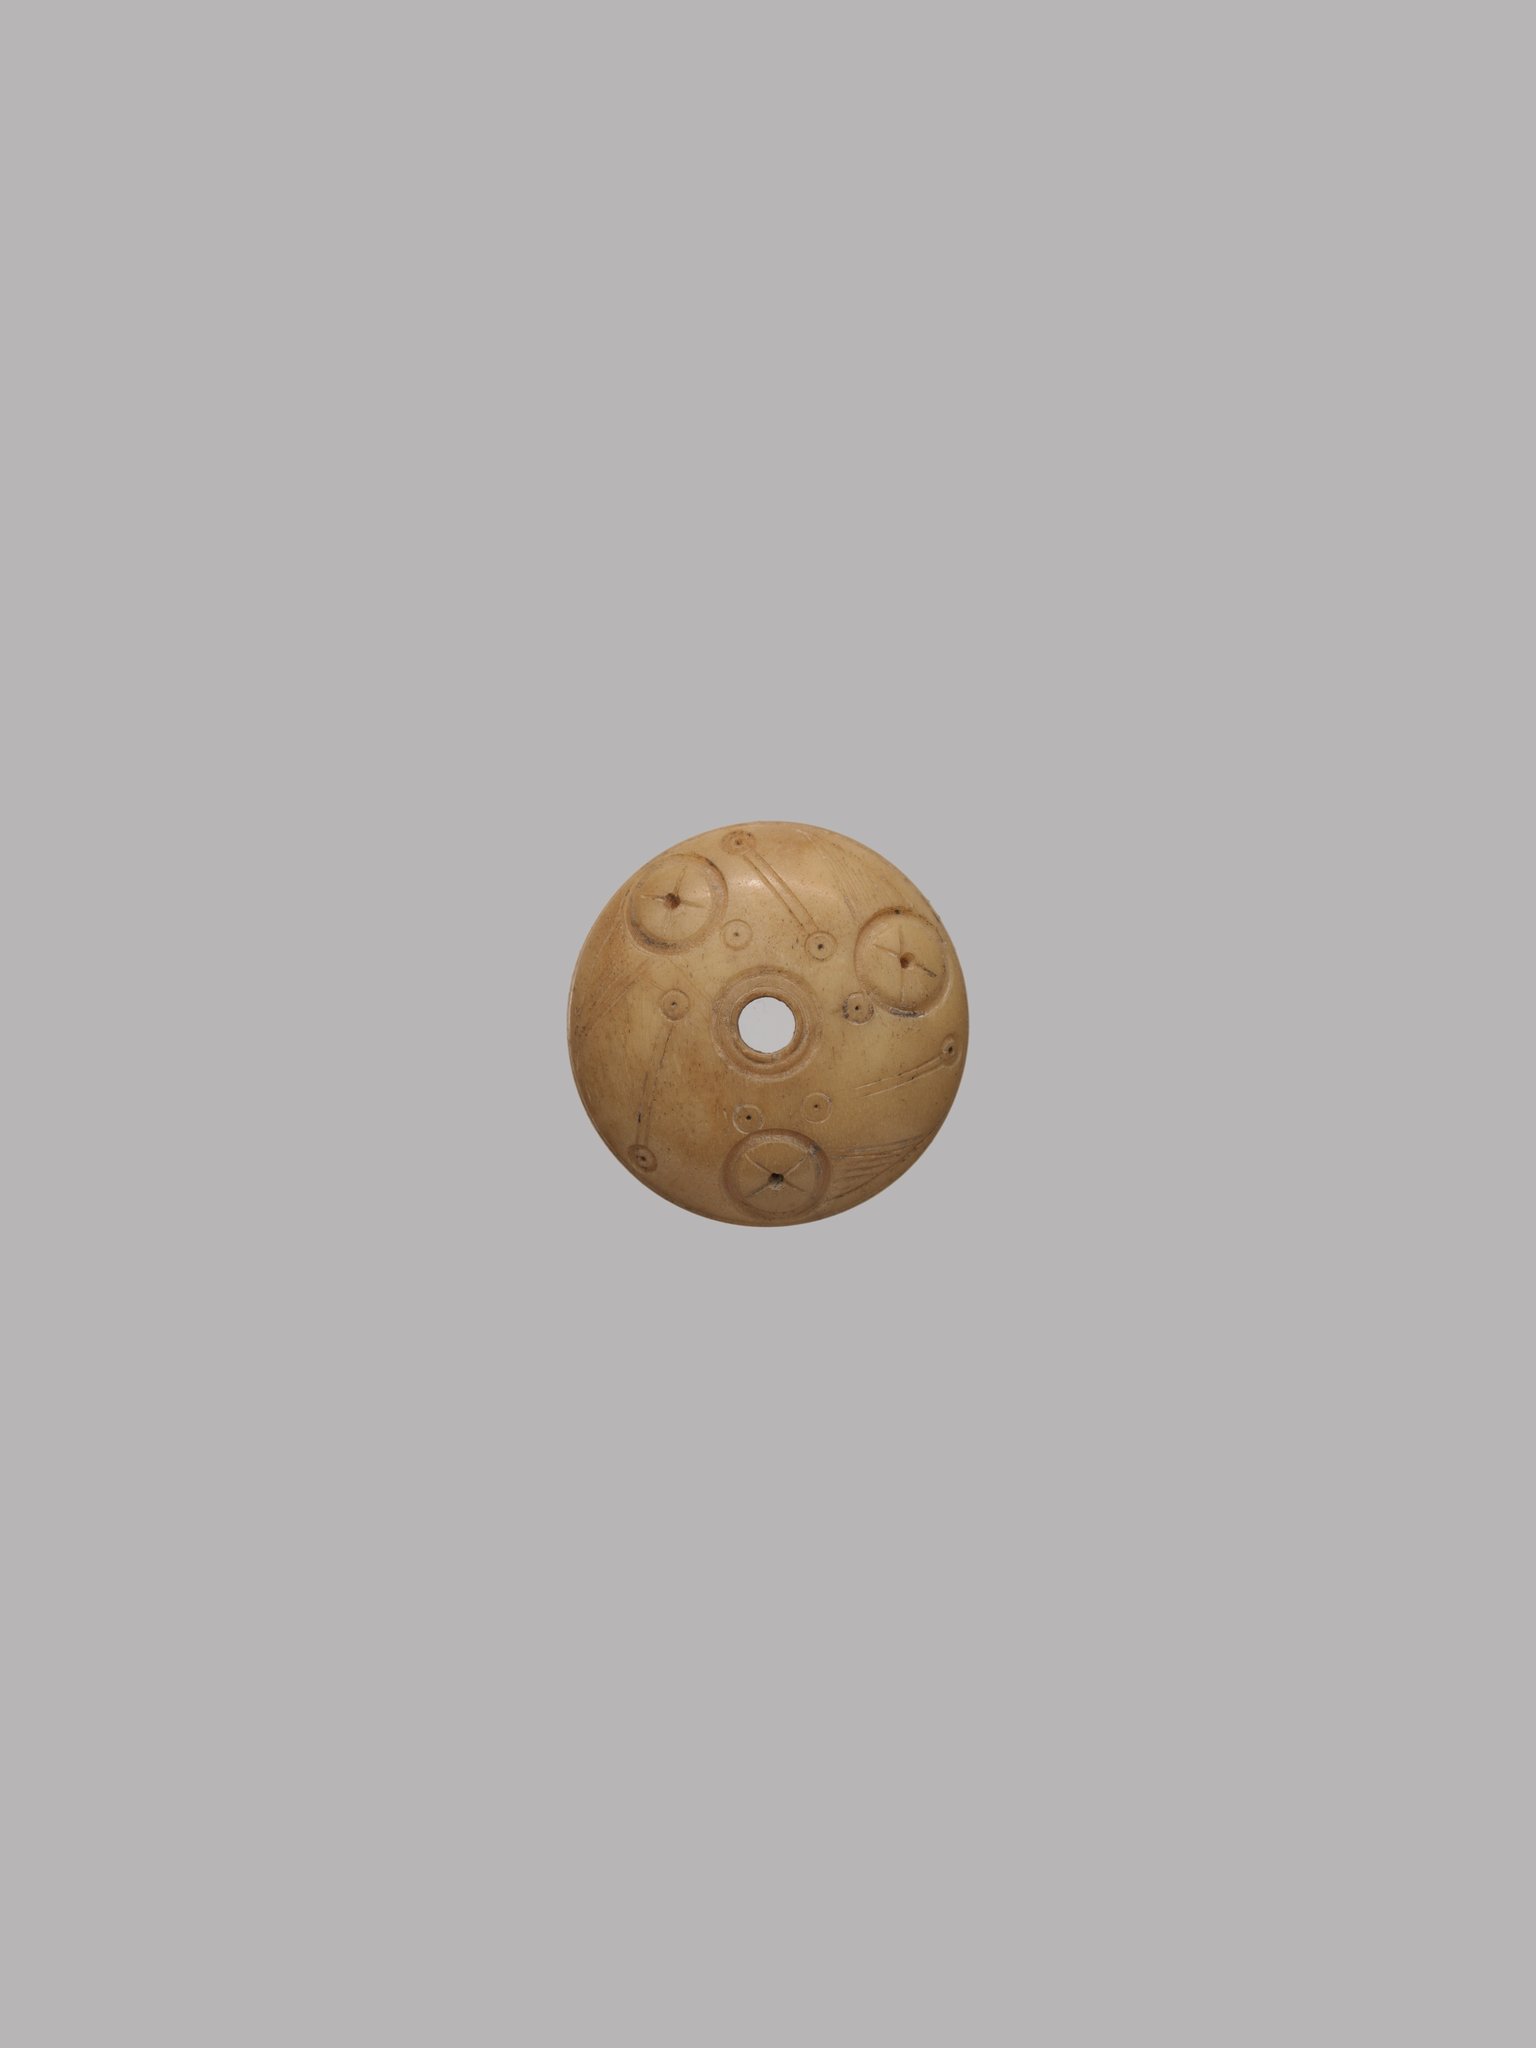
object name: button or spindle whorl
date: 801-1000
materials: bone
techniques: incising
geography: iran